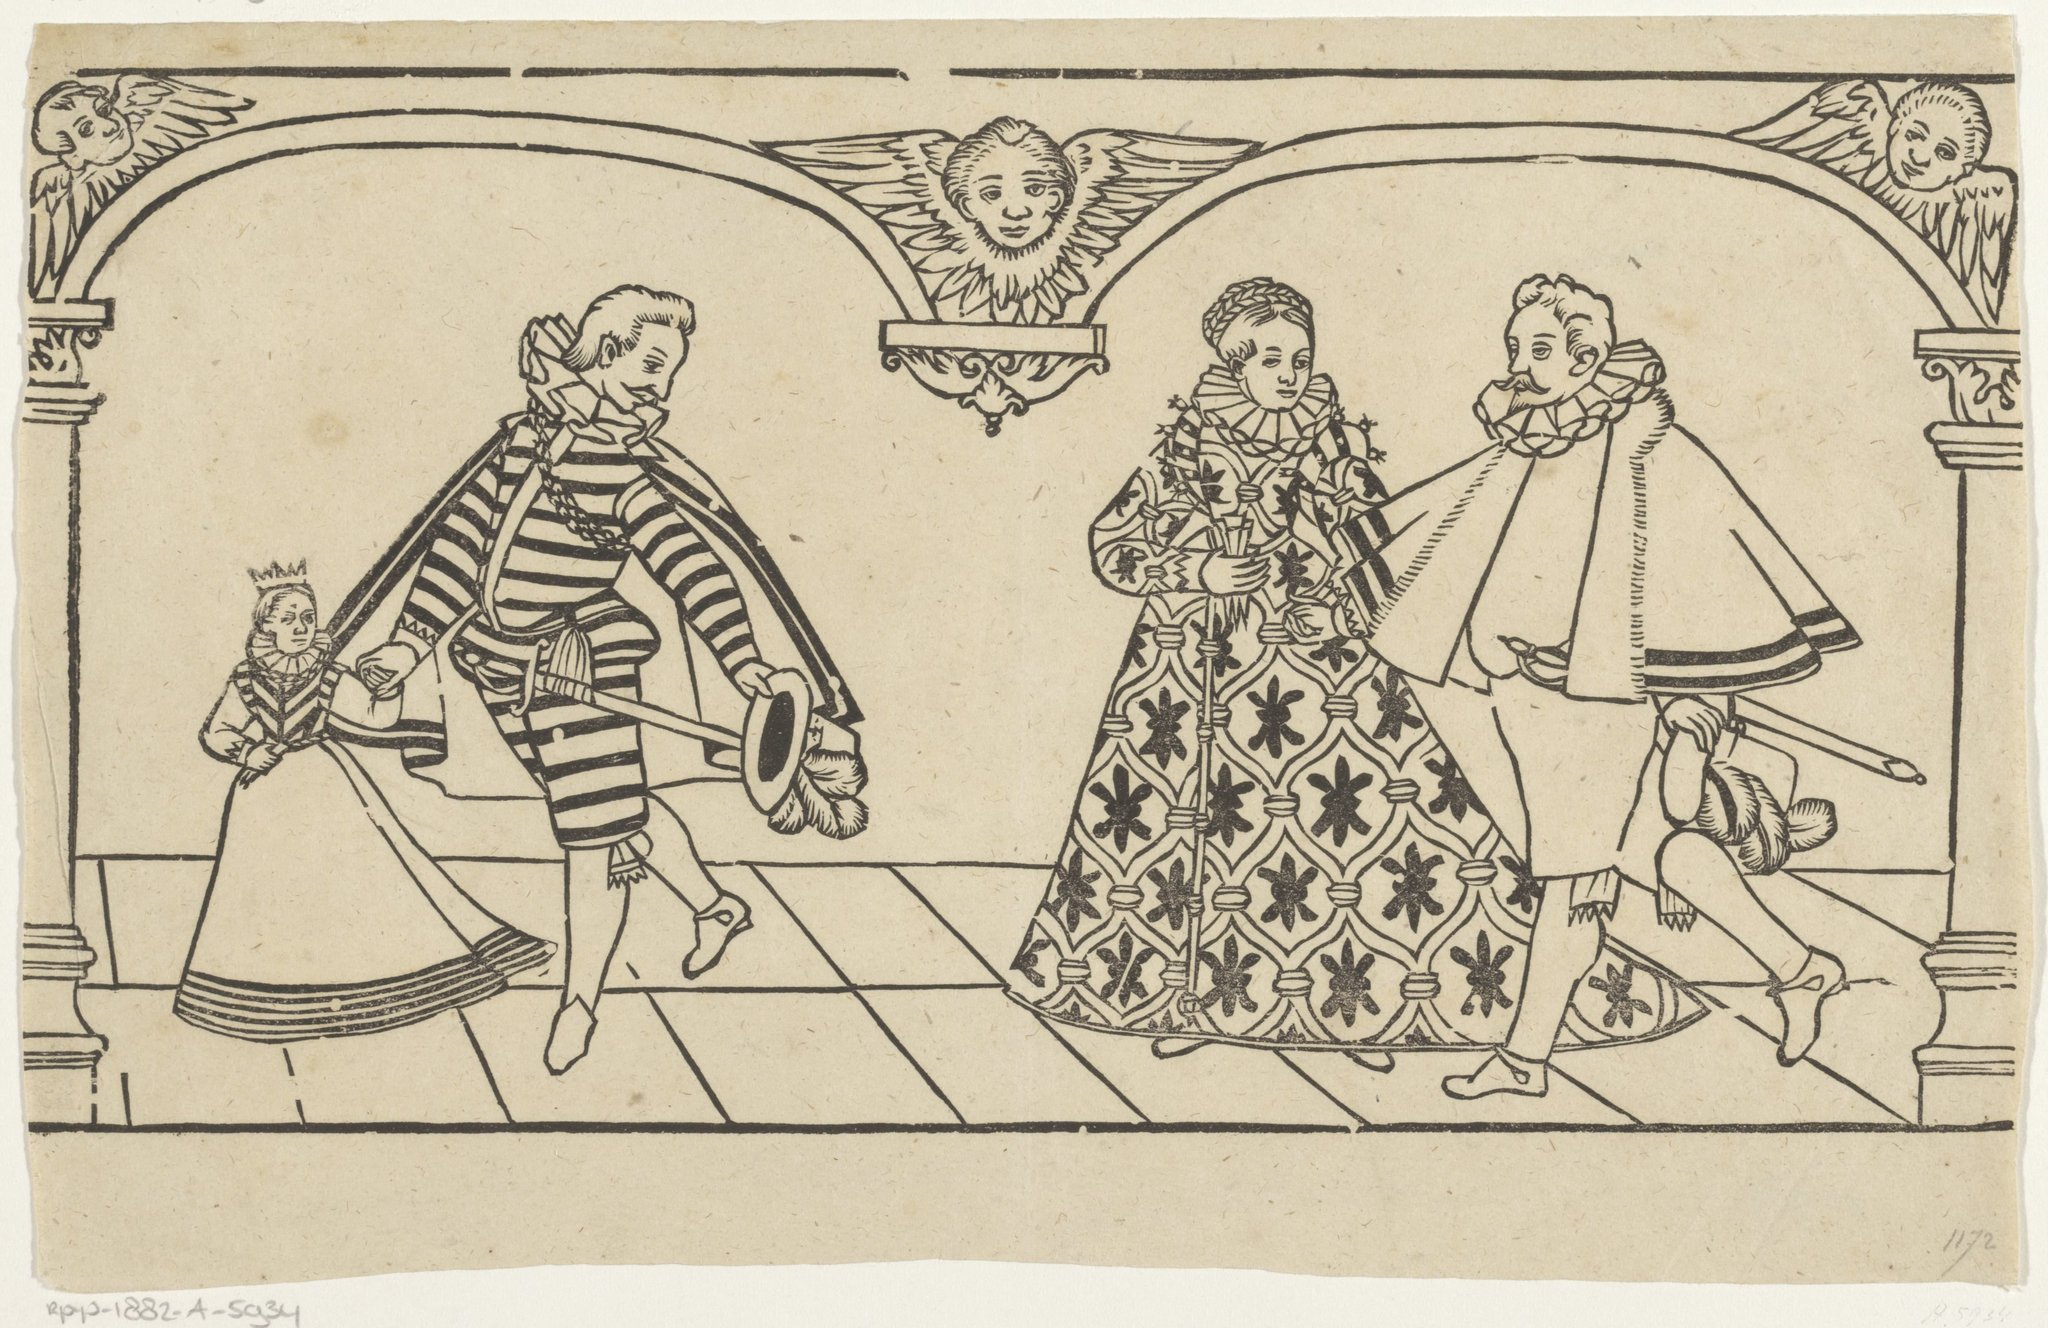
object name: print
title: Twee dansende paren op een bal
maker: Anonymous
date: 1600-1699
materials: paper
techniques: woodcut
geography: netherlands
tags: 43a23(+4)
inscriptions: collector's mark: Lugt 2228